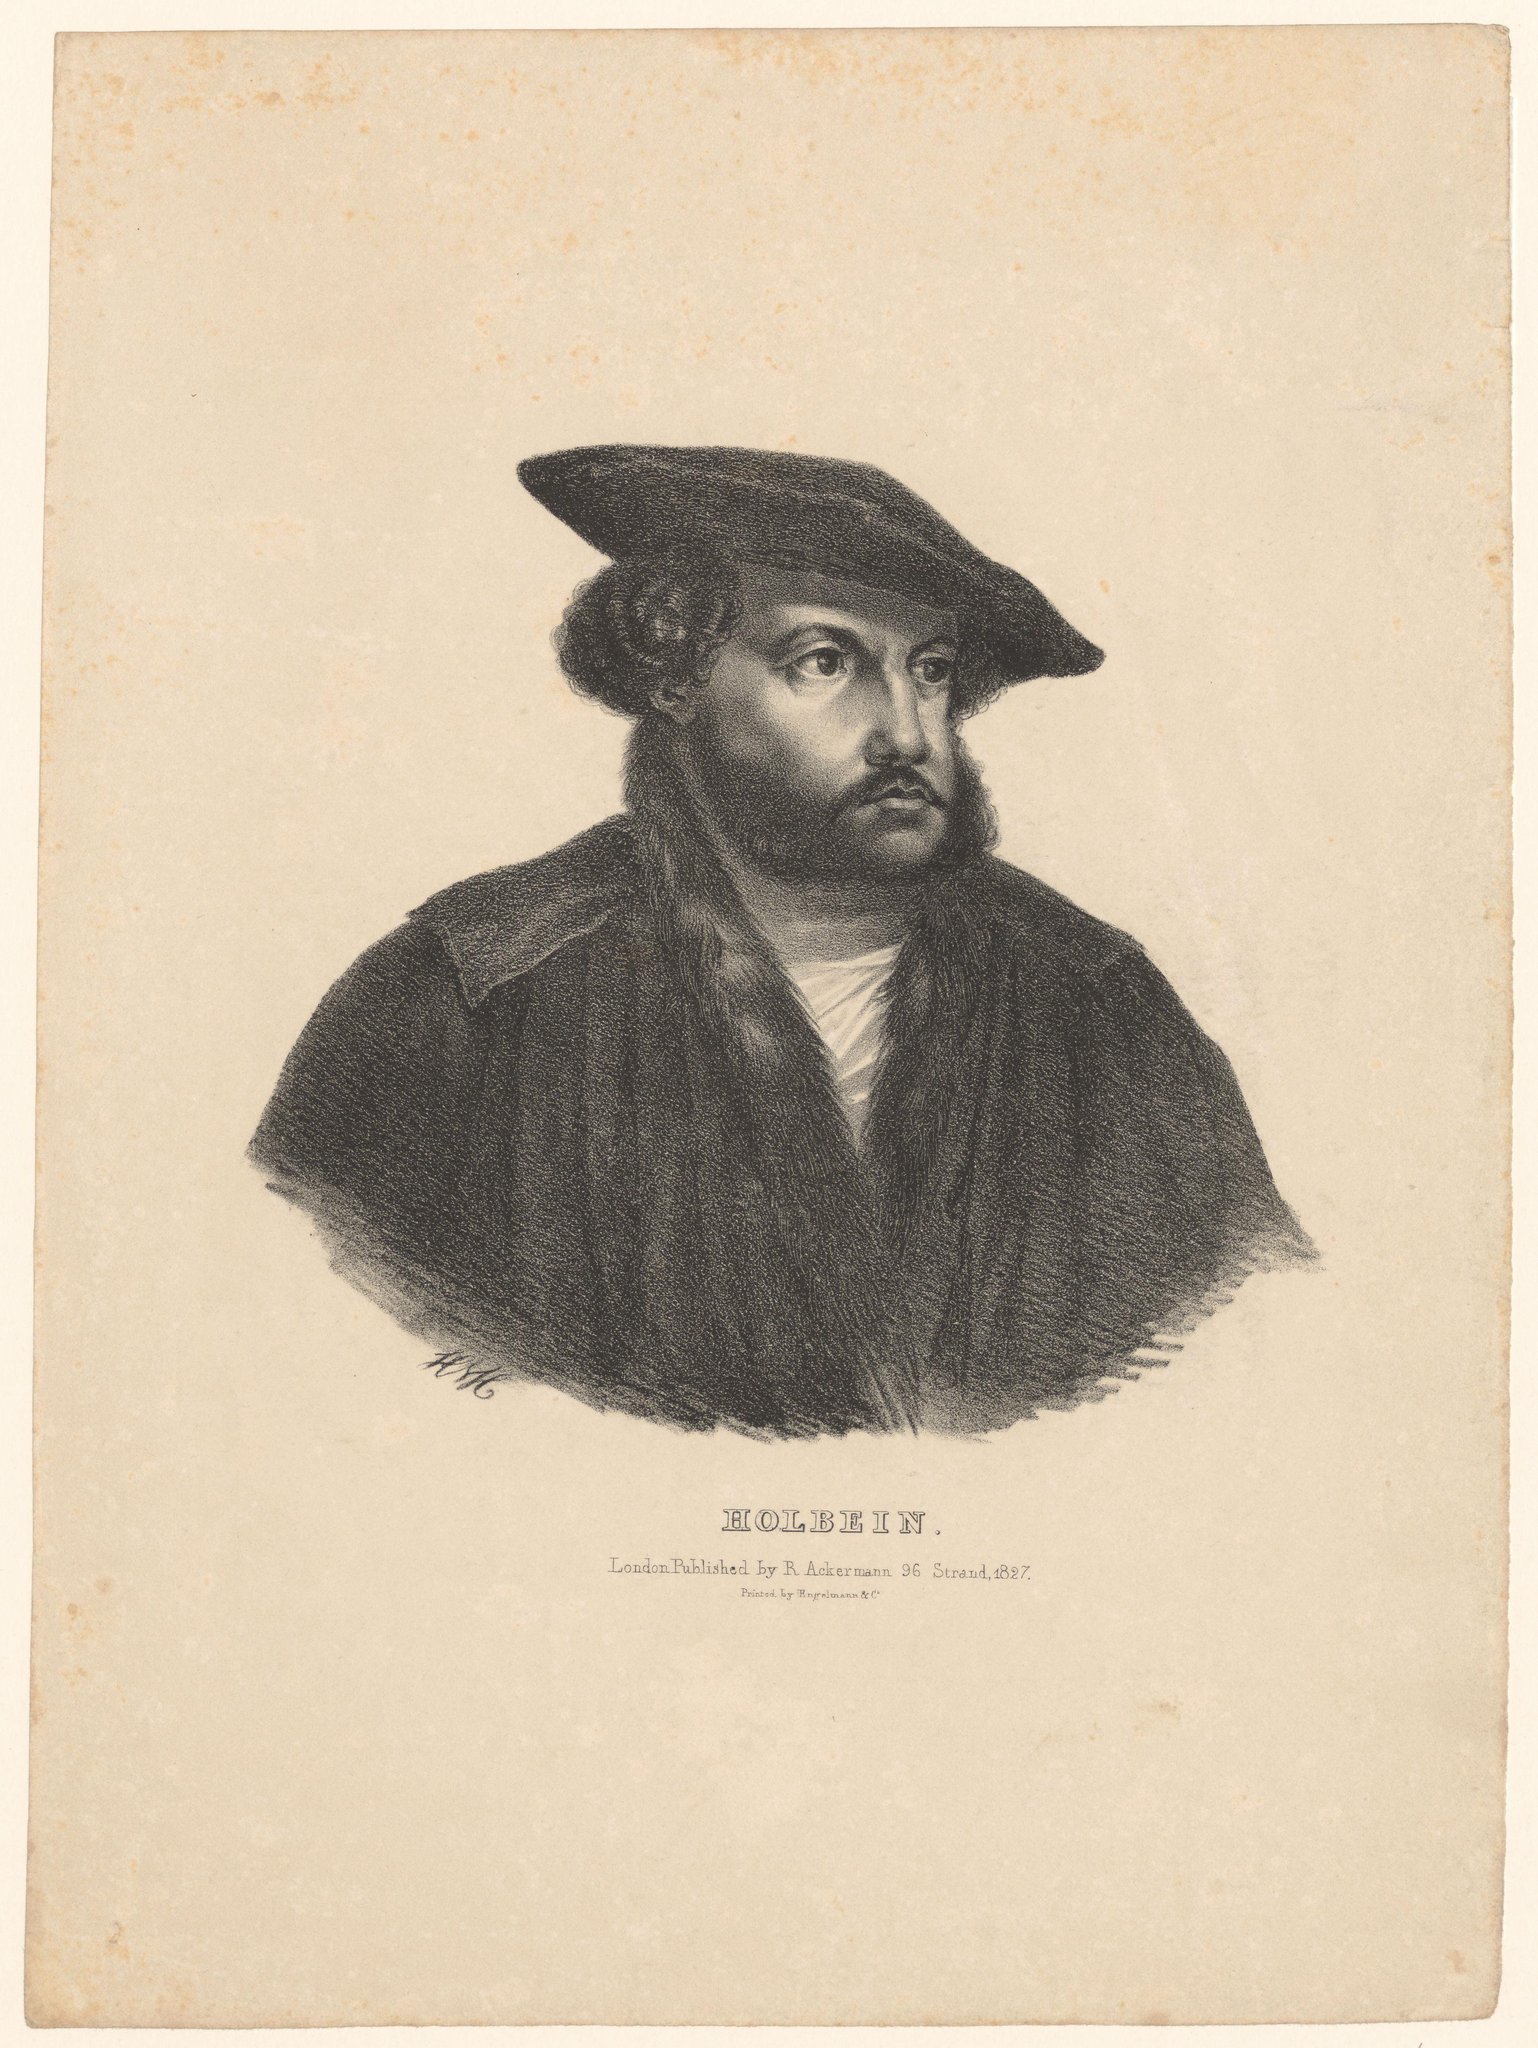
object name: print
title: Zelfportret van Hans Holbein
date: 1827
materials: paper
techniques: lithograph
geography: london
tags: london, painter, draughtsman, hans holbein (ii), head-gear, historical persons, portrait, self-portrait of artist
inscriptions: collector's mark: Lugt 2228